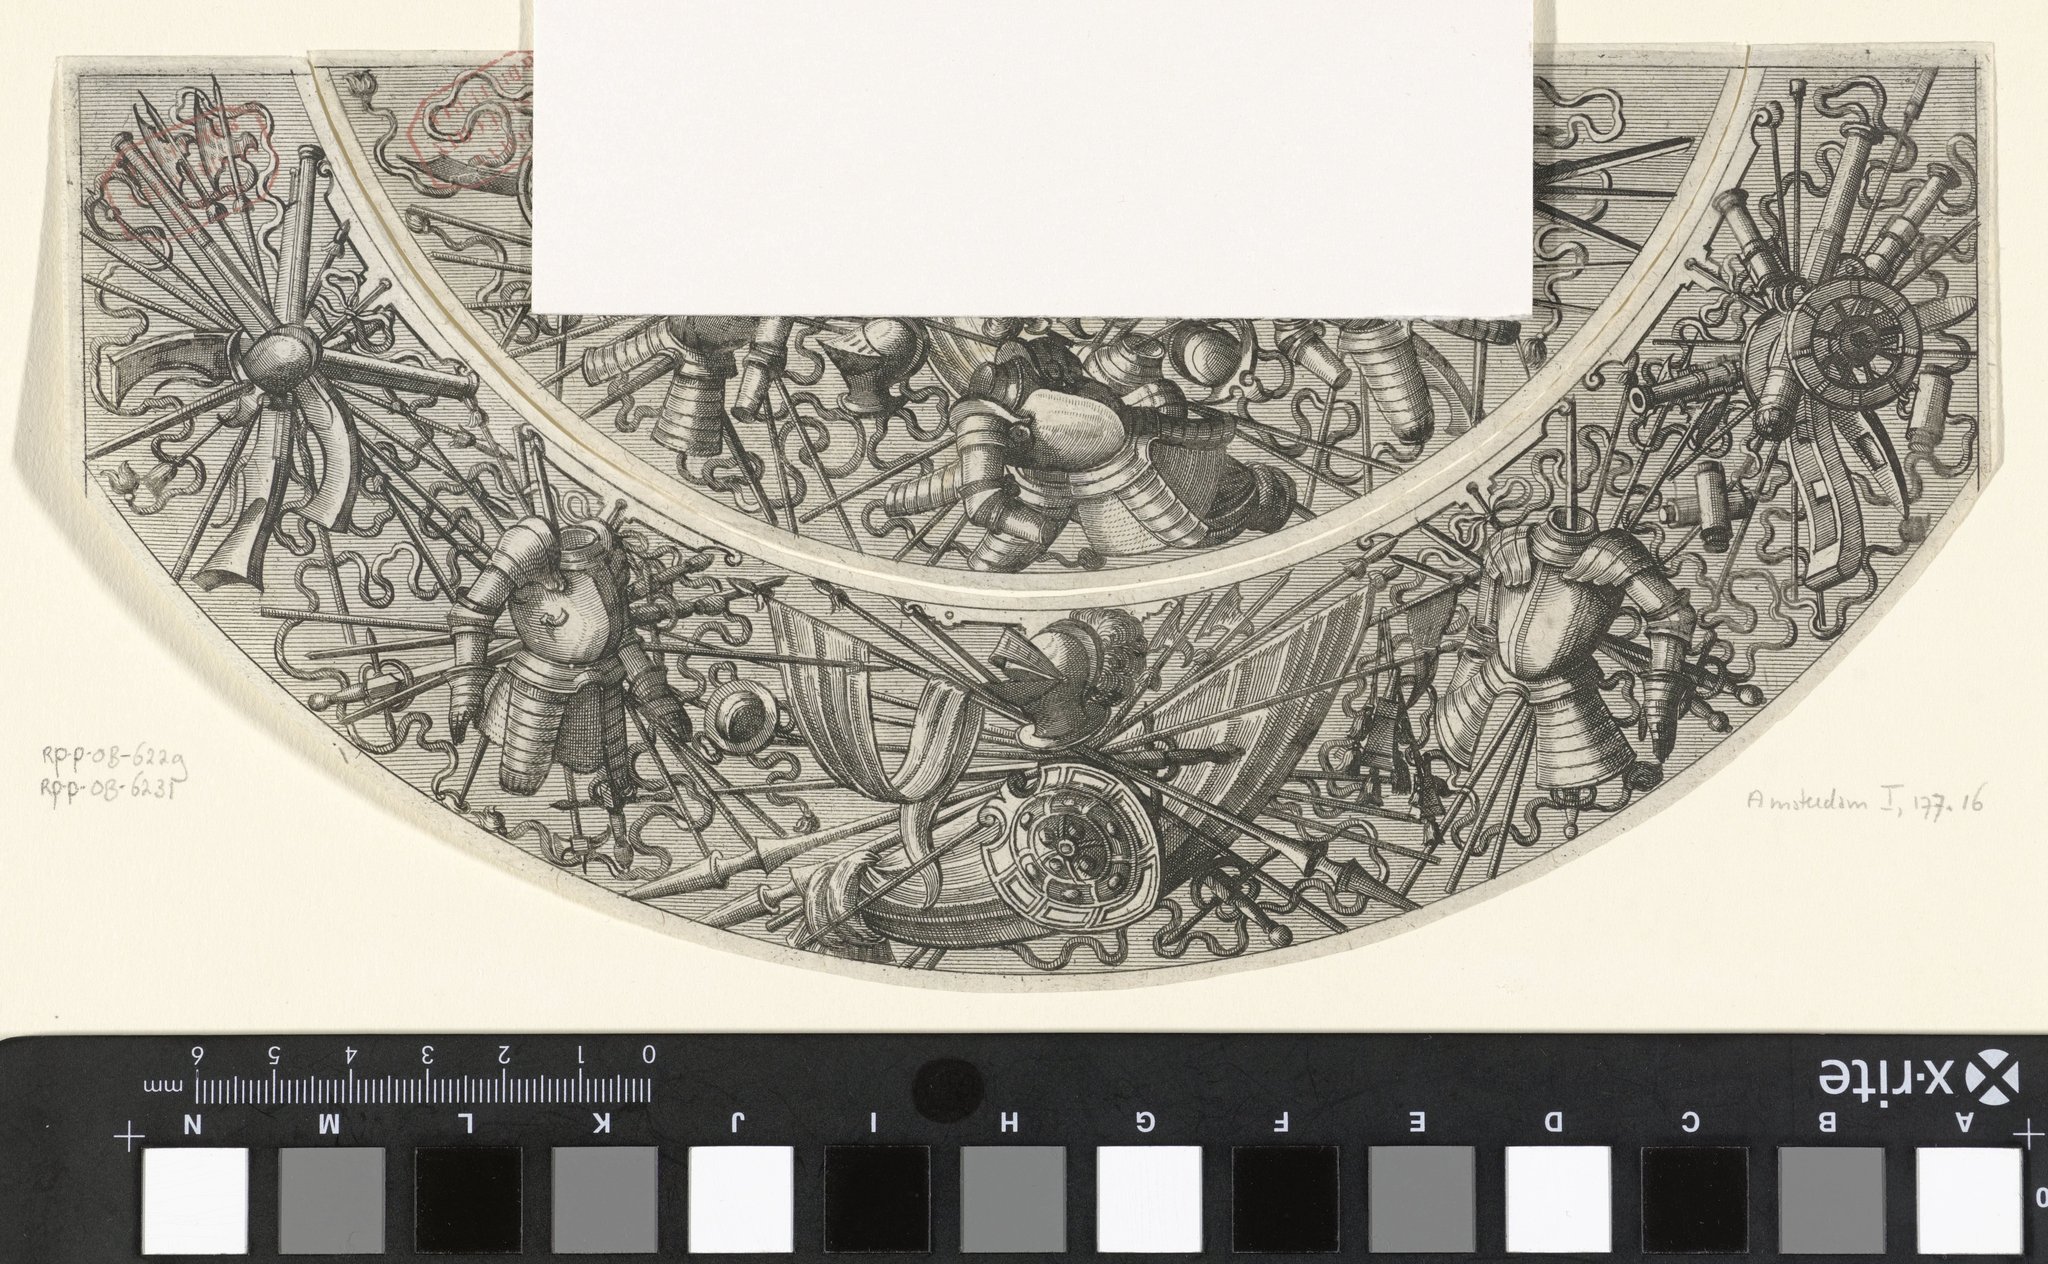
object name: ornament print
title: Panoplia sev armamentarium…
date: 1572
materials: paper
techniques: etching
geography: netherlands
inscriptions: collector's mark: Lugt 2275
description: Het fries toont gekruiste vaandels tussen kurassen, musketten (links) en een kanon op een affuit (rechts). Uit serie, bestaande uit een titelblad en 16 bladen.